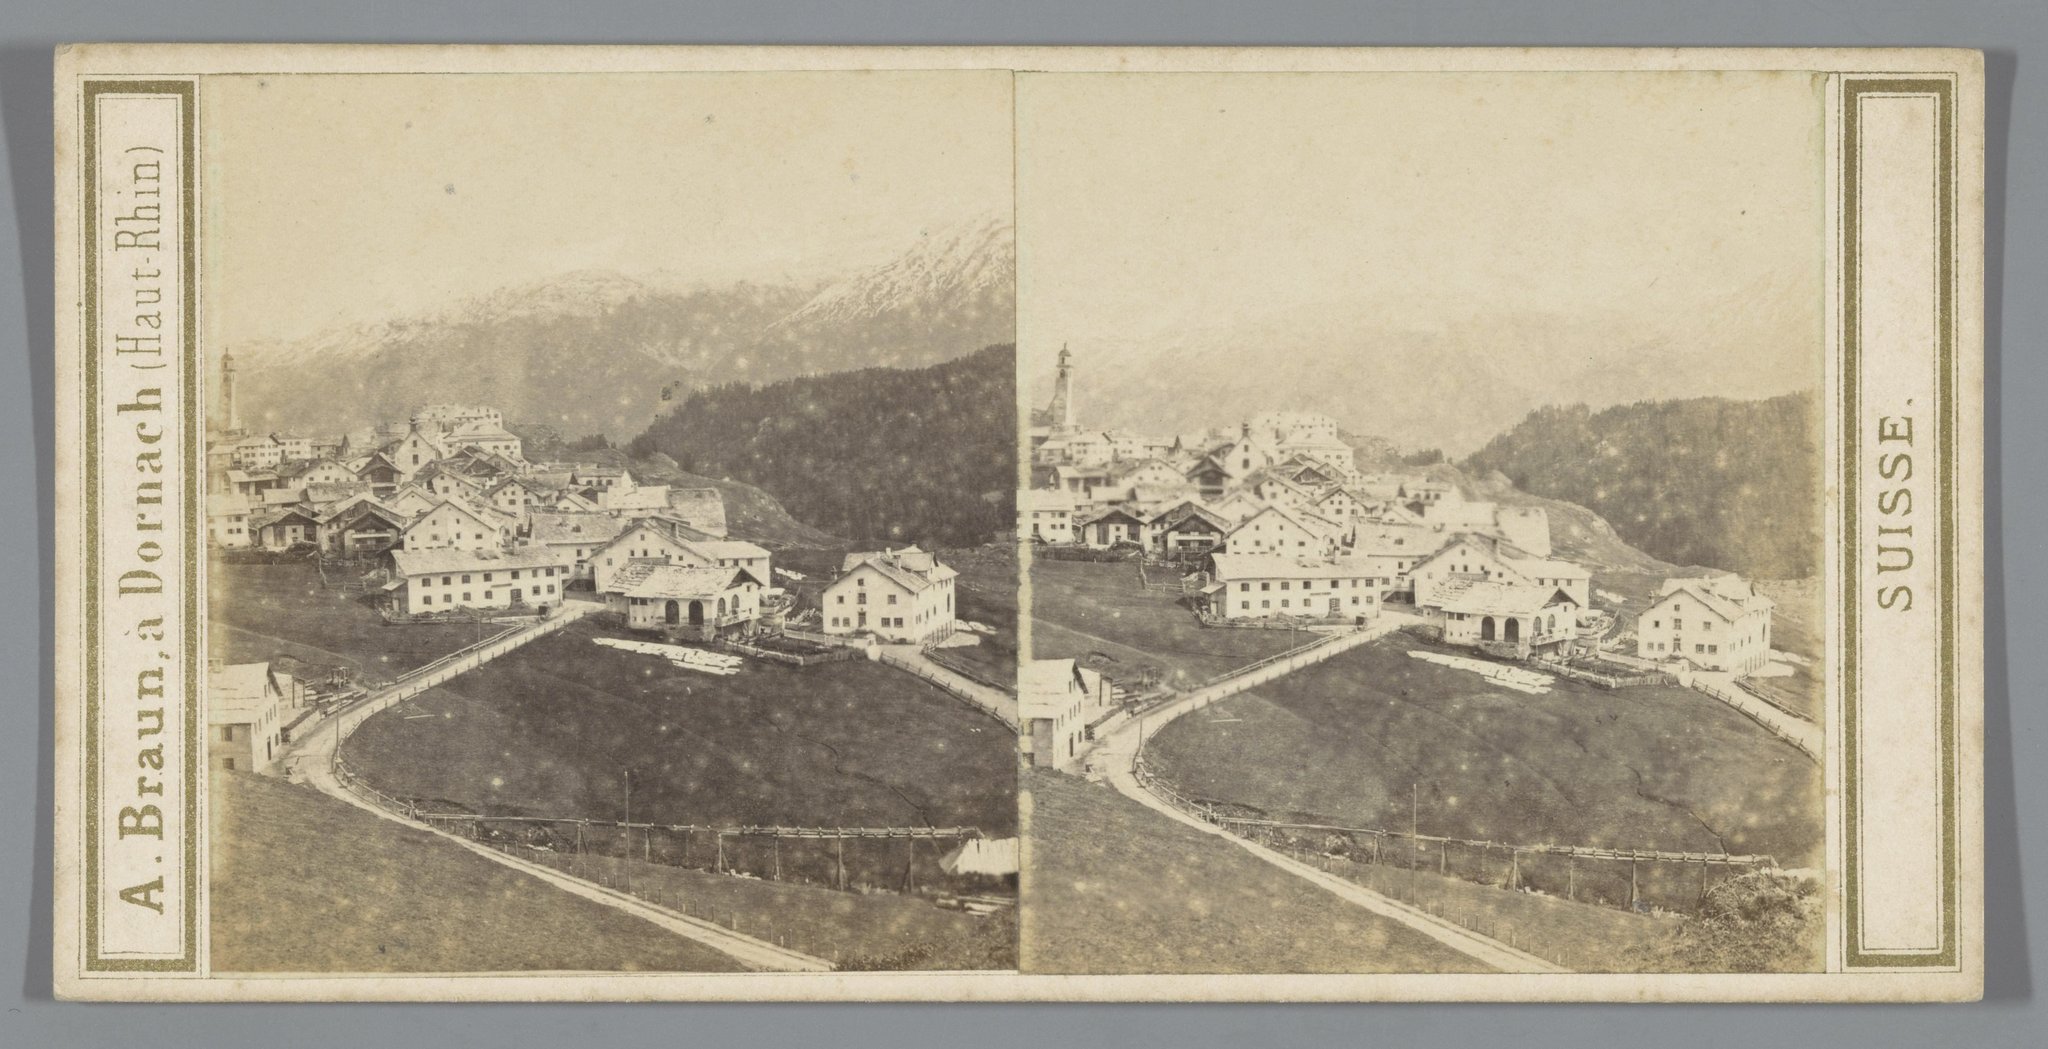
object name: stereograph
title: Haute Engadine. Village de St-Maurice (5710')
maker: Anonymous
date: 1860-1866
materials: cardboard, paper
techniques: albumen print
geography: dornach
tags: city-view in general; 'veduta', mountains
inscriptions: number: ‘No 3447.’